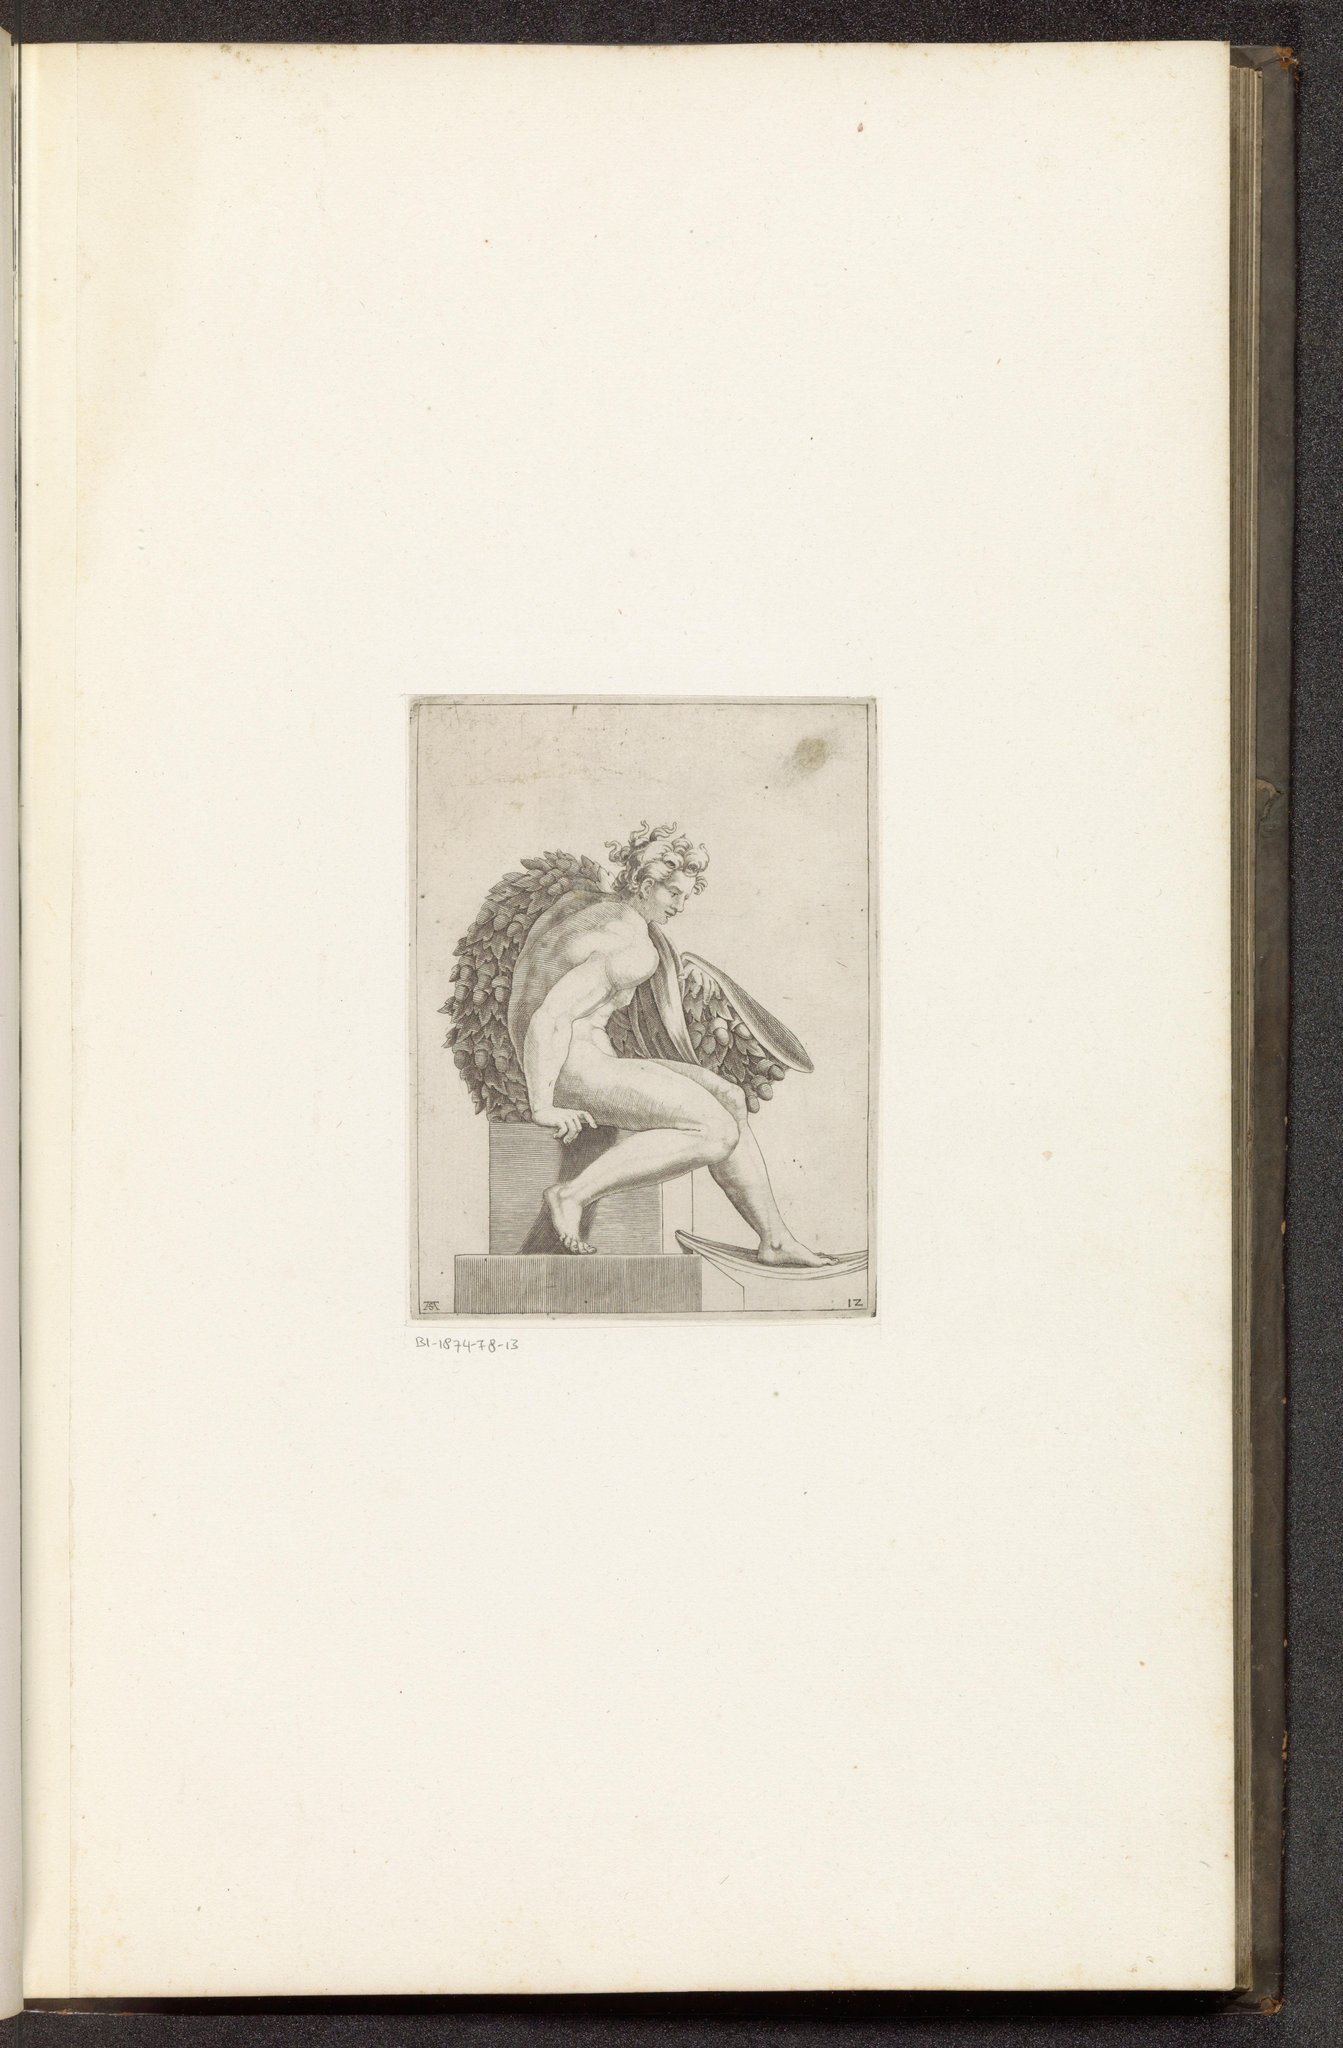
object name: print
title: Zittend naakt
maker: adamo scultori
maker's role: painter, print maker, sculptor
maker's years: 1530-1585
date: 1585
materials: paper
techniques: engraving, intaglio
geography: italy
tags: the (nude) human figure; 'corpo humano' (ripa), fruits: acorn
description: Zittende naakte man, naar rechts gedraaid, met over zijn schouder een guirlande van eikels. Eén van de 'ignudi' (naakte mannen) van Michelangelo's plafondschildering. Genummerd rechtsonder: 12. De prent maakt deel uit van een album.